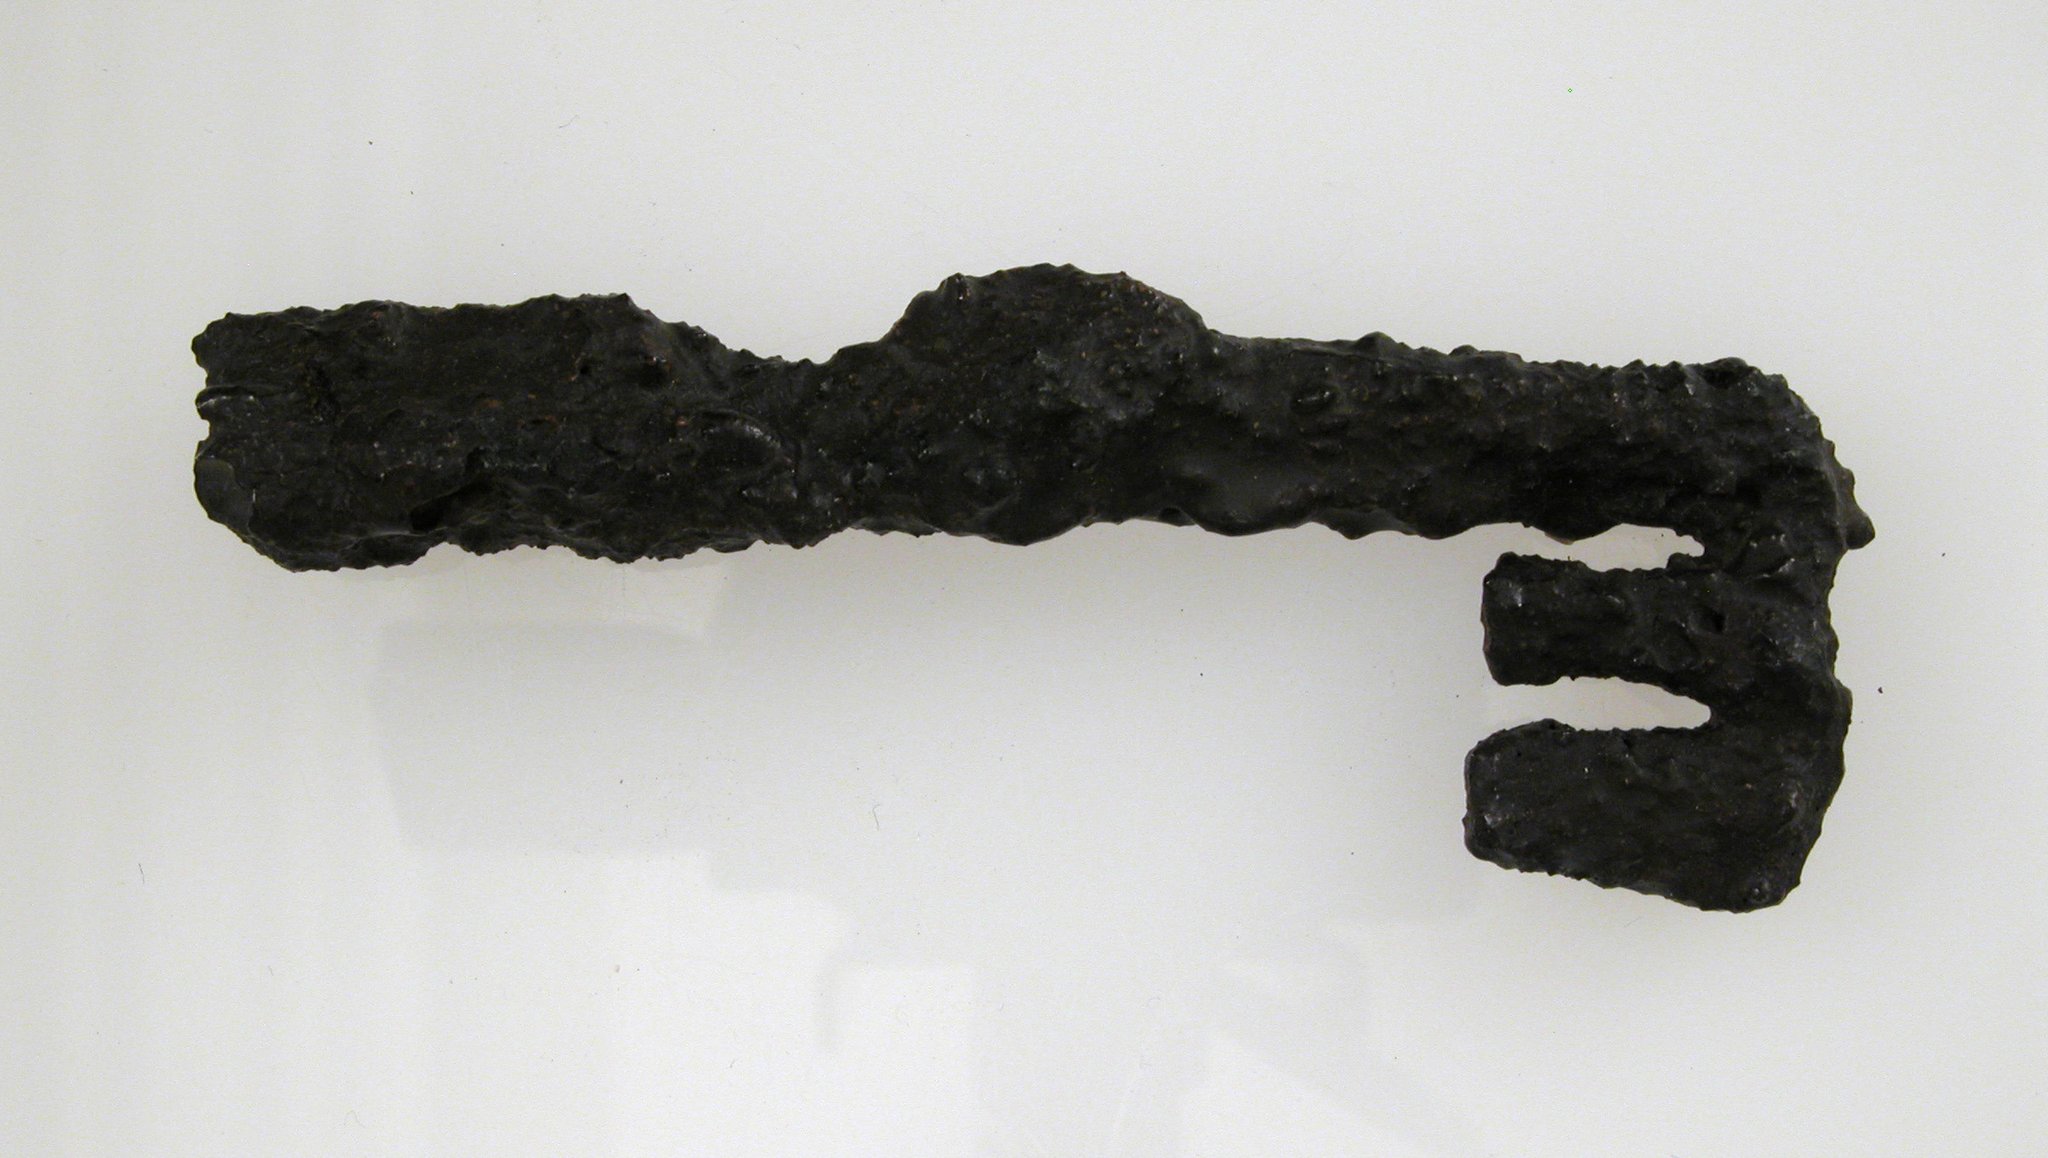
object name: key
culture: frankish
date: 601-700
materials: iron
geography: germany